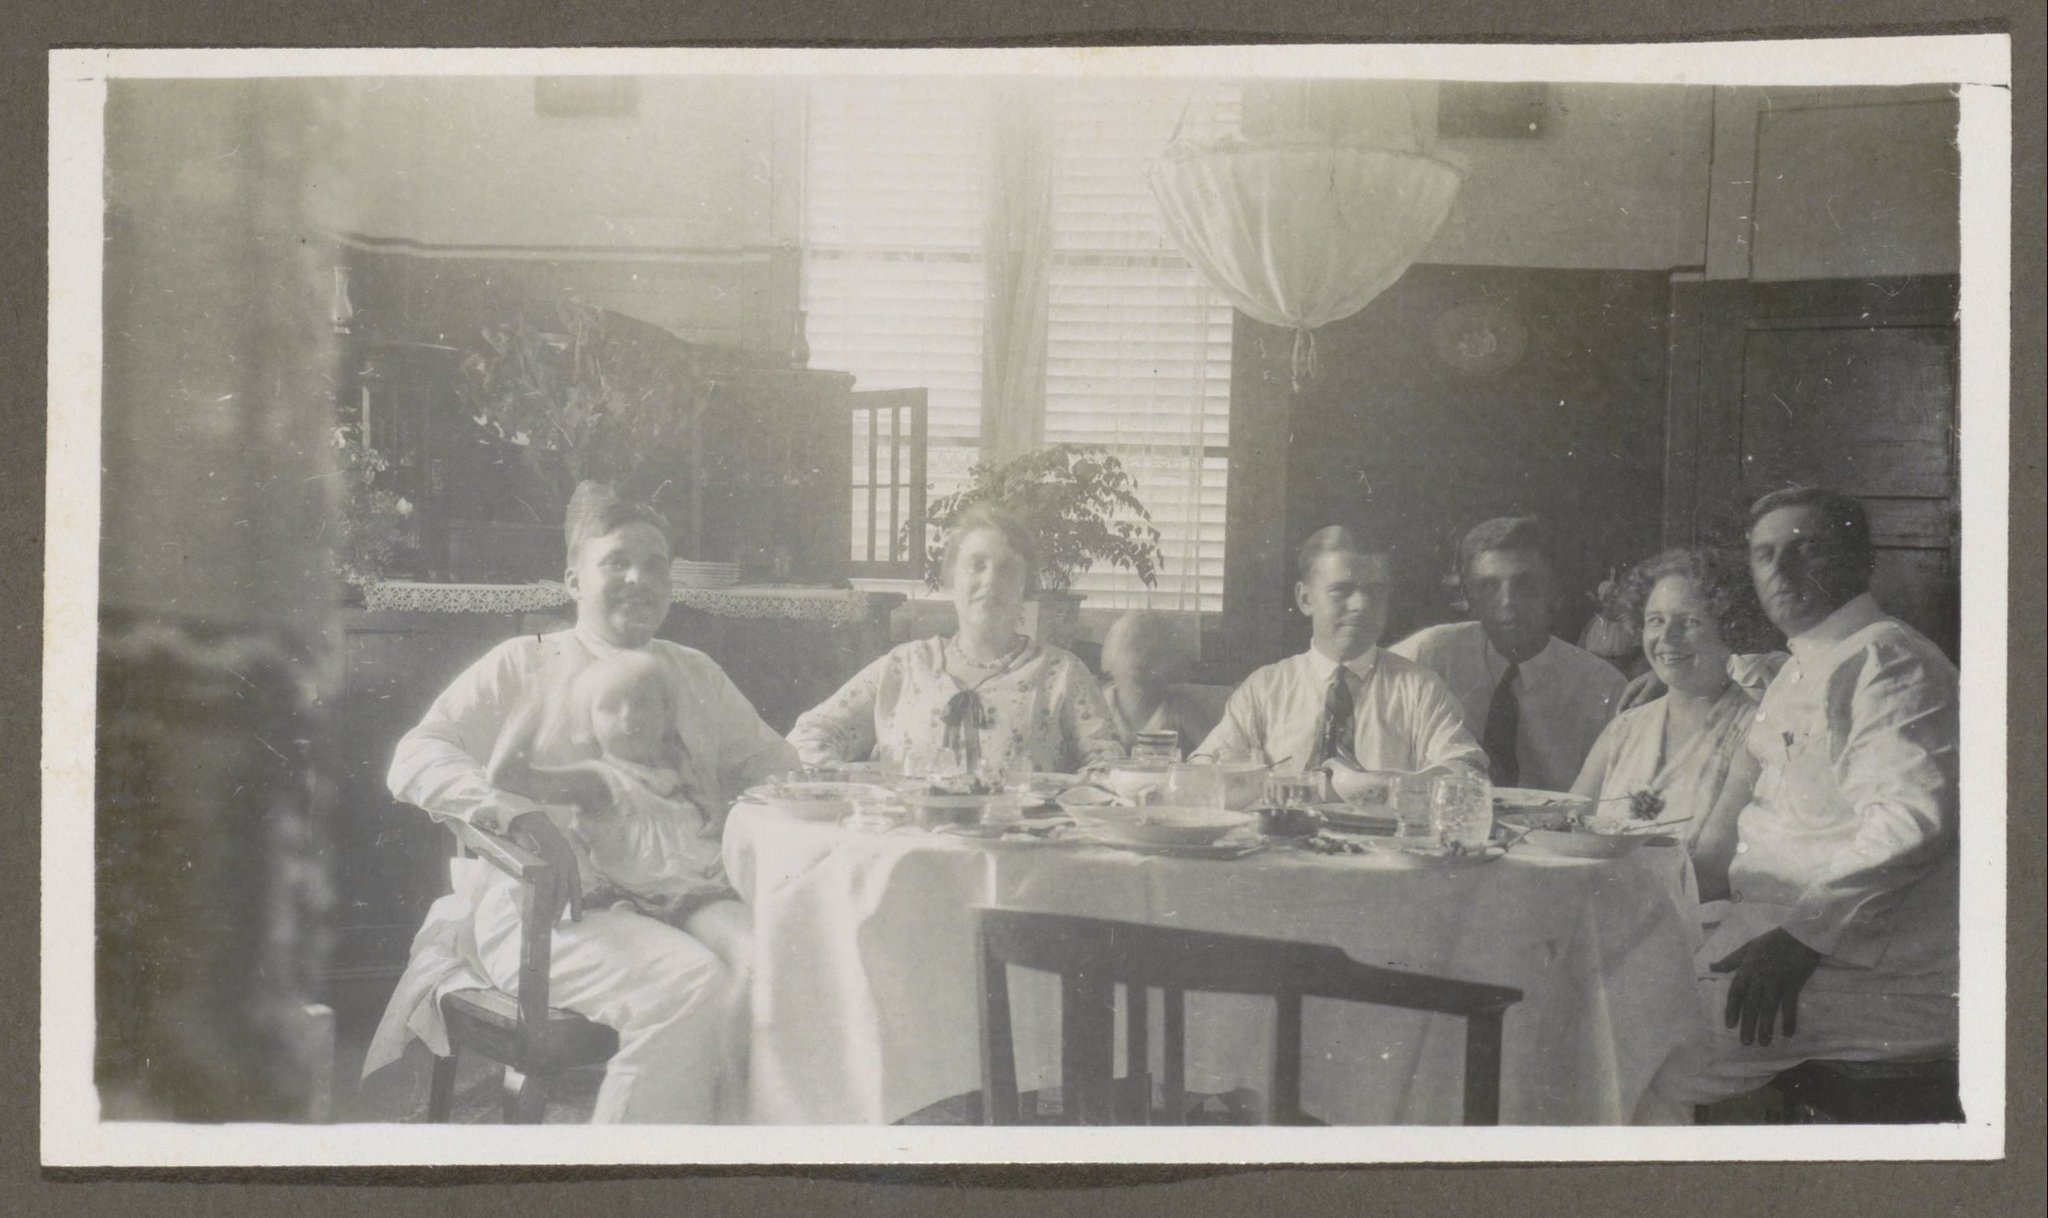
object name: photograph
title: Mannen, vrouwen en kinderen rondom een gedekte tafel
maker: Anonymous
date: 1920-1930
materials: photographic support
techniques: gelatin silver print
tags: dining-room, dutch east indies, the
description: Onderdeel van familiealbum Nederlands-Indië.